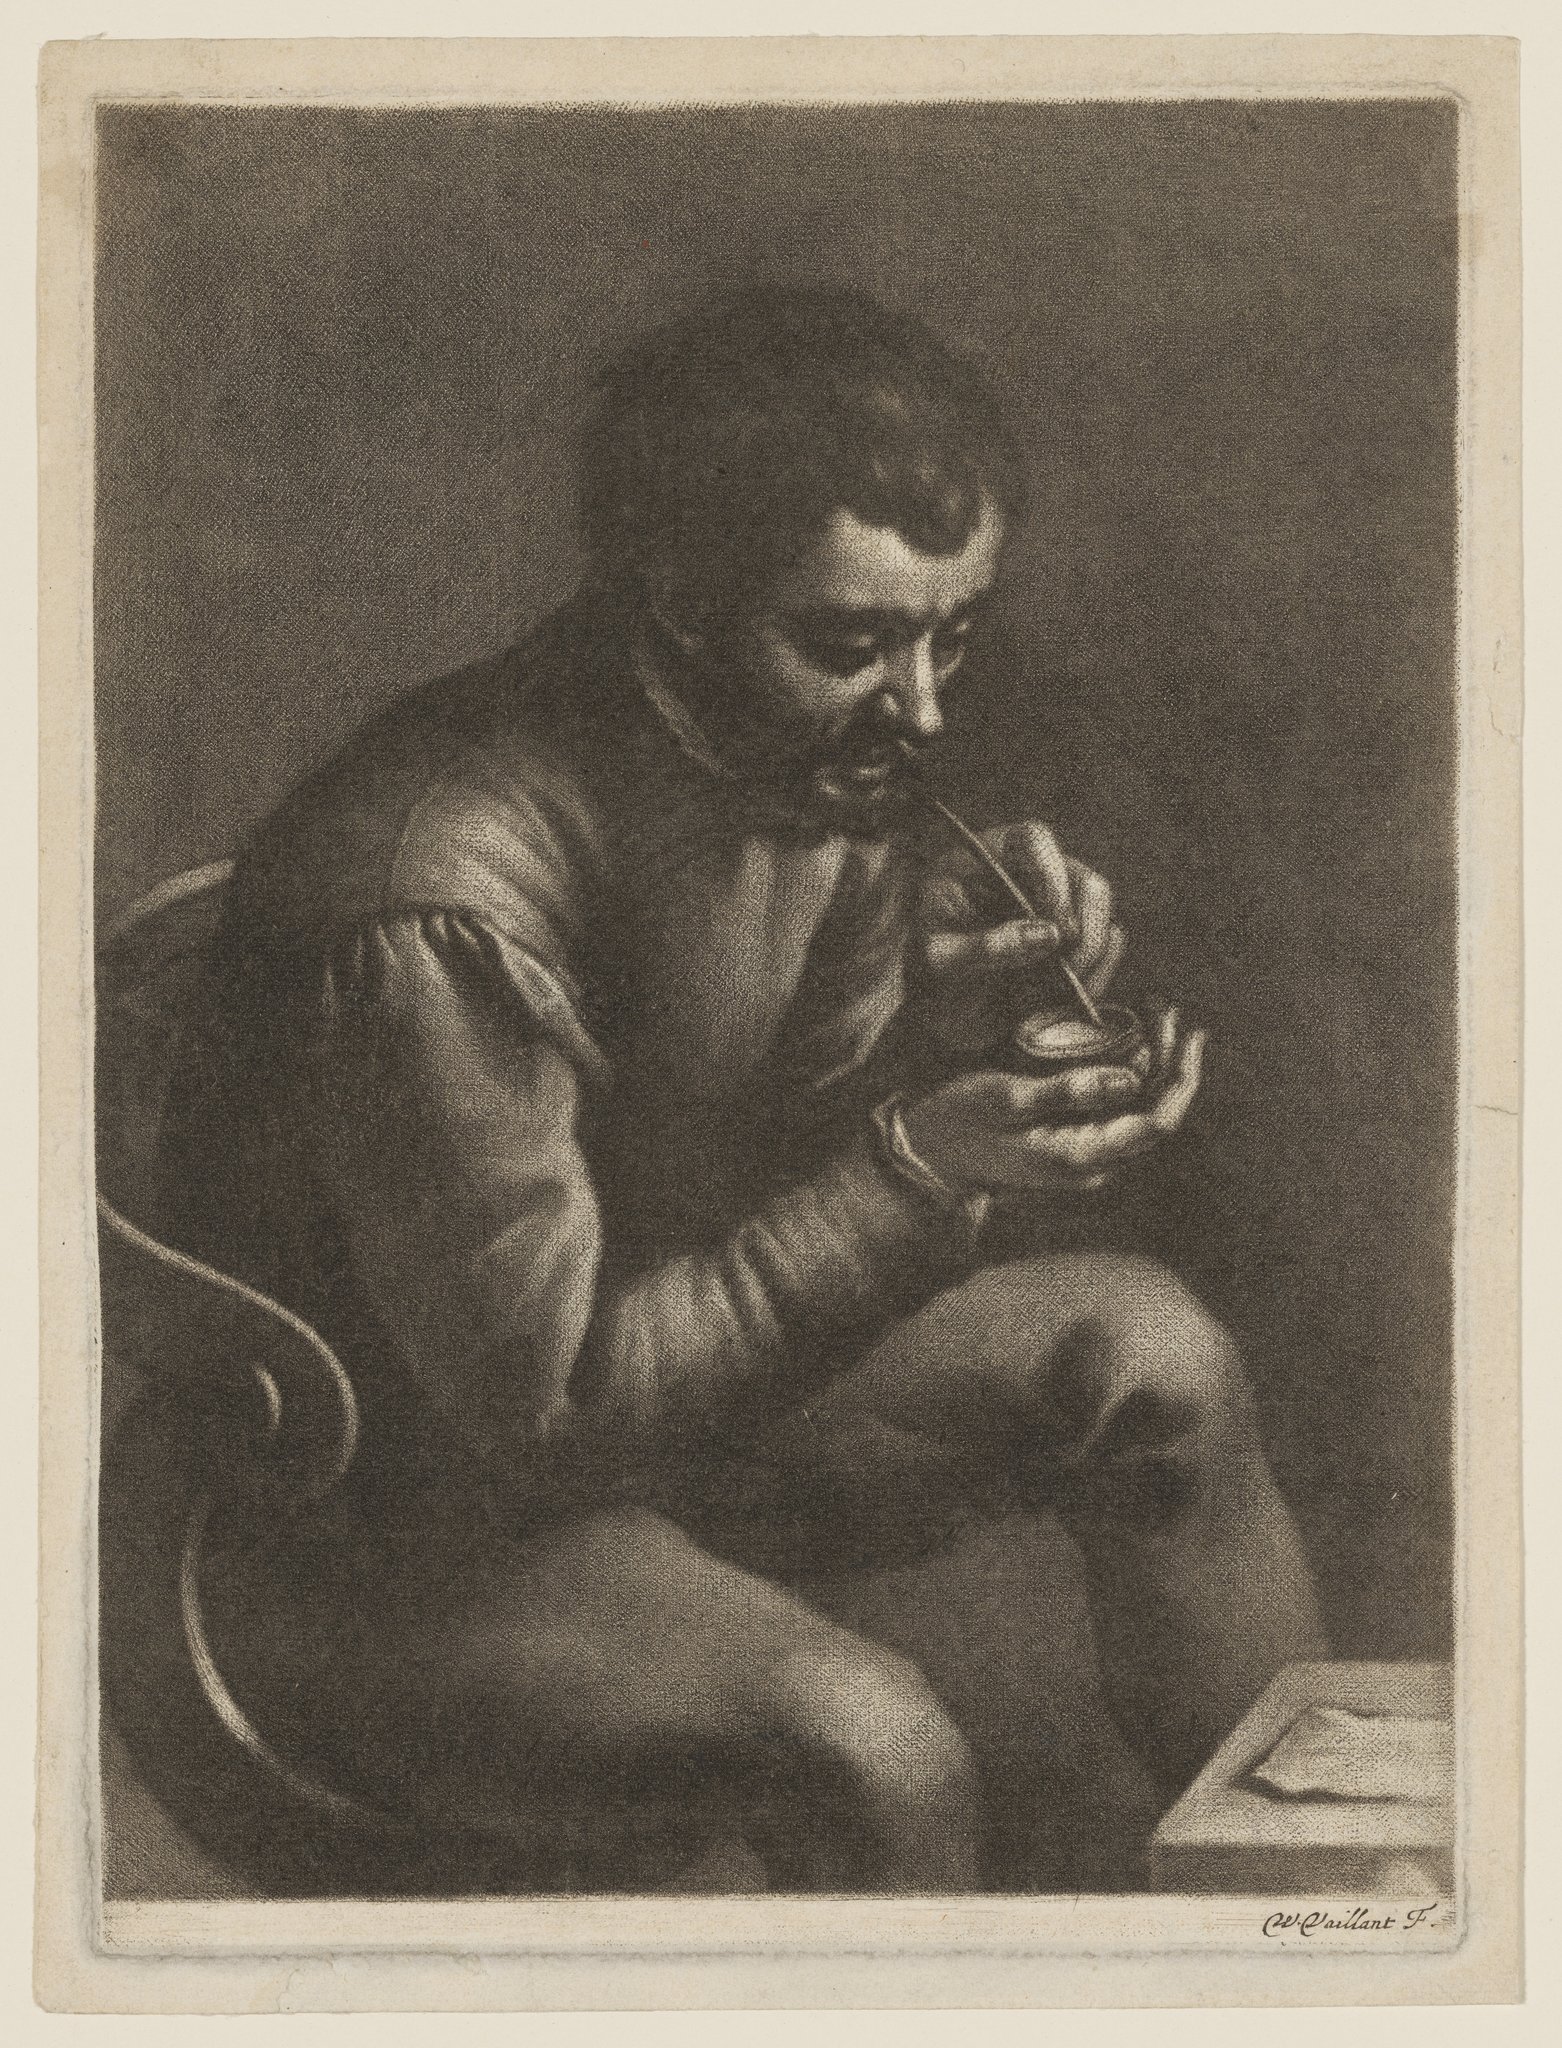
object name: print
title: Draughtsman with an Ink-Pot and a Pen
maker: wallerant vaillant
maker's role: artist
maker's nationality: dutch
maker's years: 1623-1677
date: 1634-1666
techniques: mezzotint